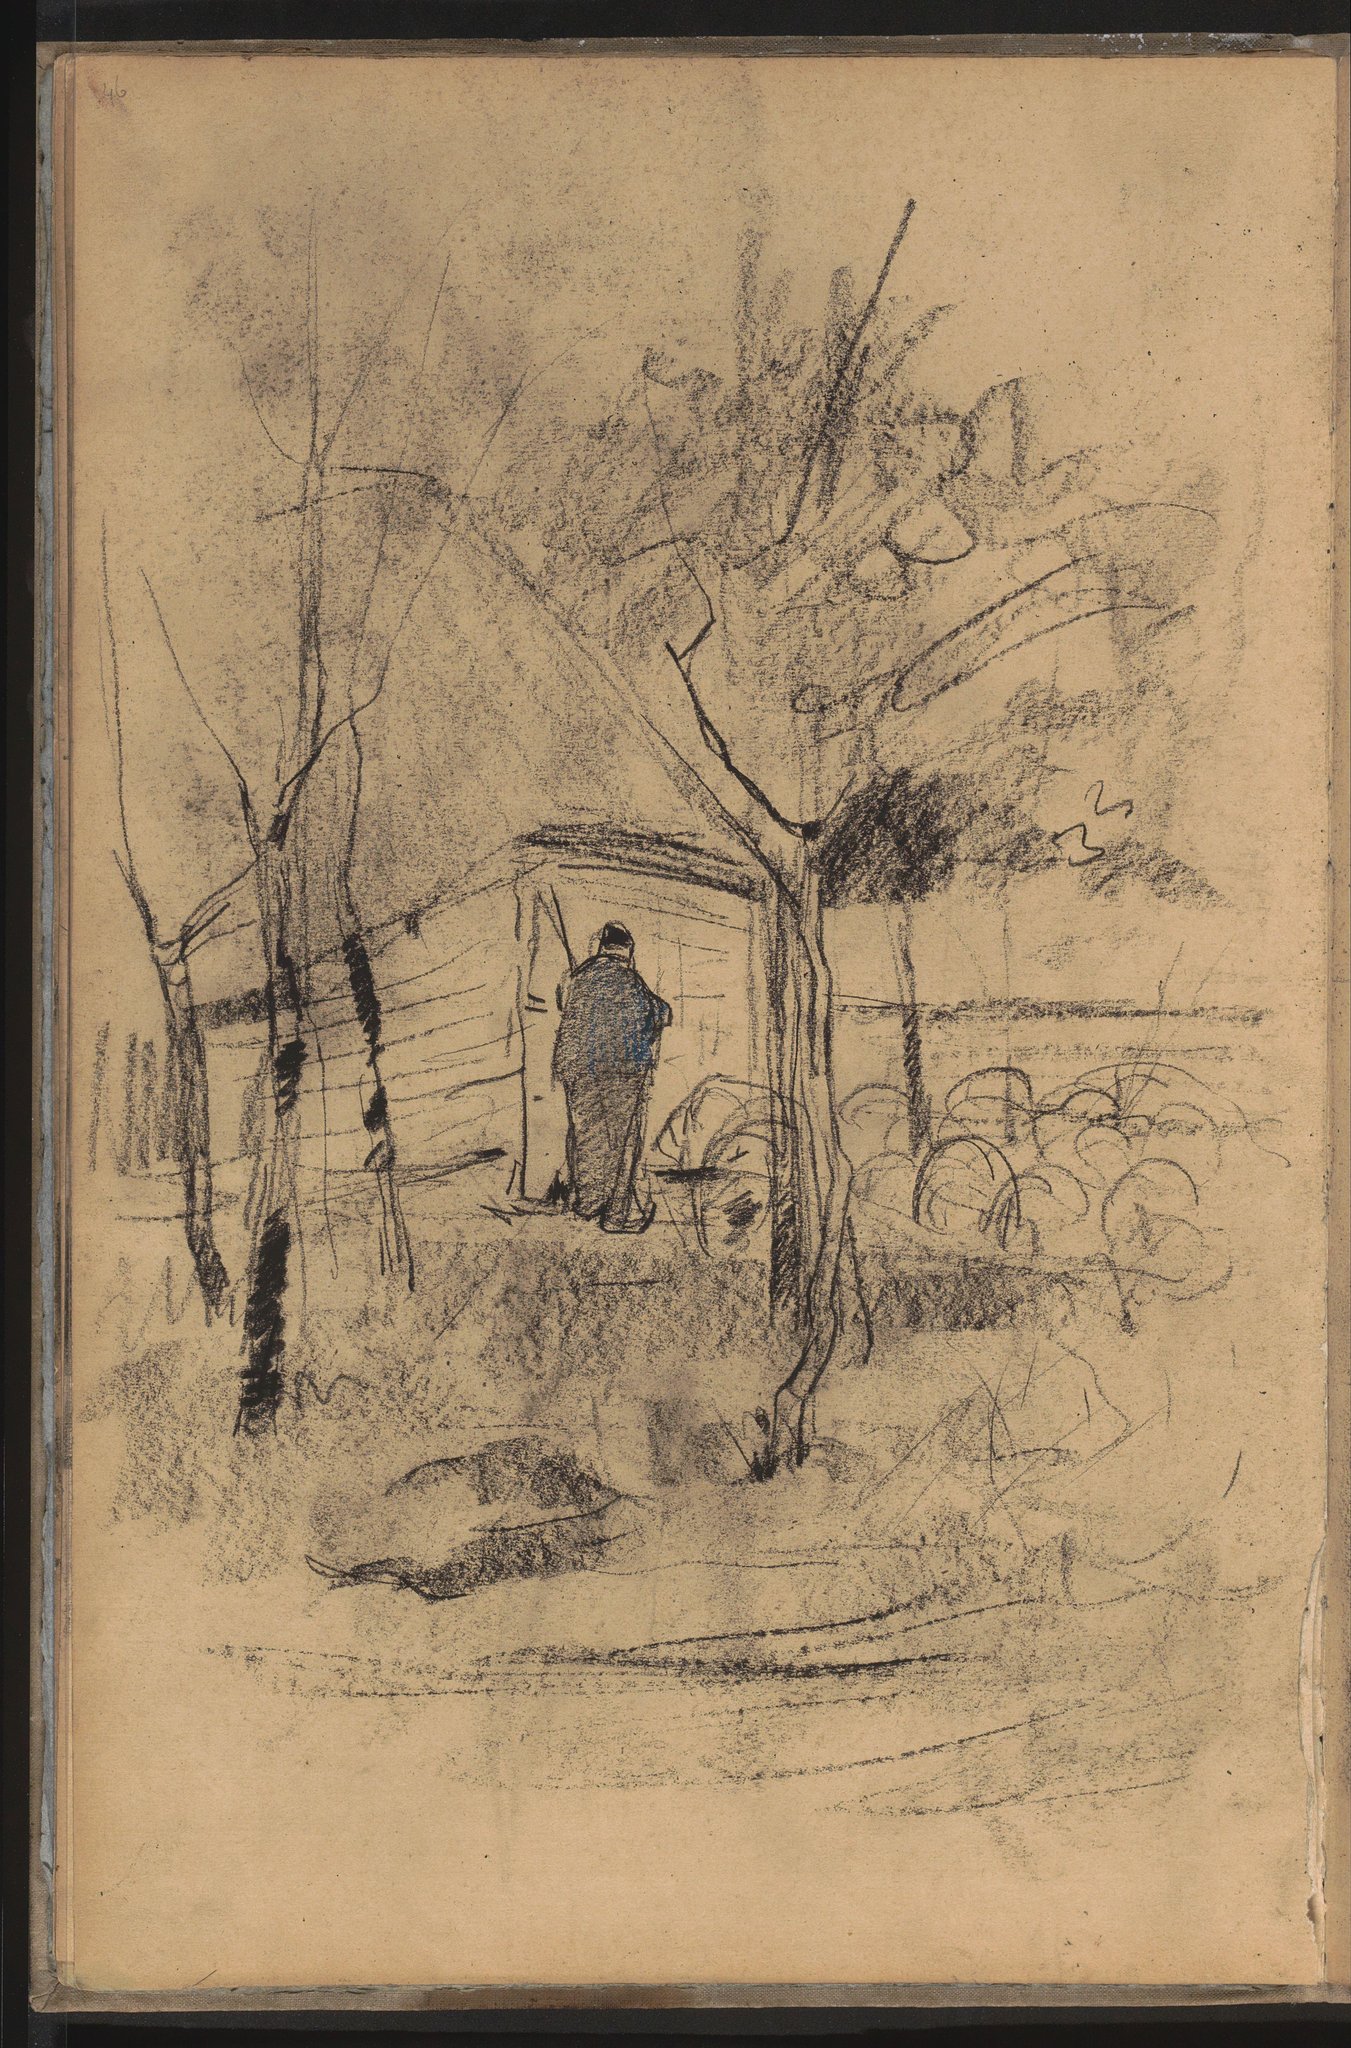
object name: sketchbook leaf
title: Schaapherder met zijn kudde bij een stal of schaapskooi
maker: willem witsen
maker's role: draughtsman, painter, print maker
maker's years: 1860-1923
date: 1884-1887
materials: chalk, paper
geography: ewijkshoeve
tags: cattle driving, cattle driver, sheep, stall, stable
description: Pagina 46 uit een schetsboek met 45 bladen vervaardigd rond de Ewijkshoeve.